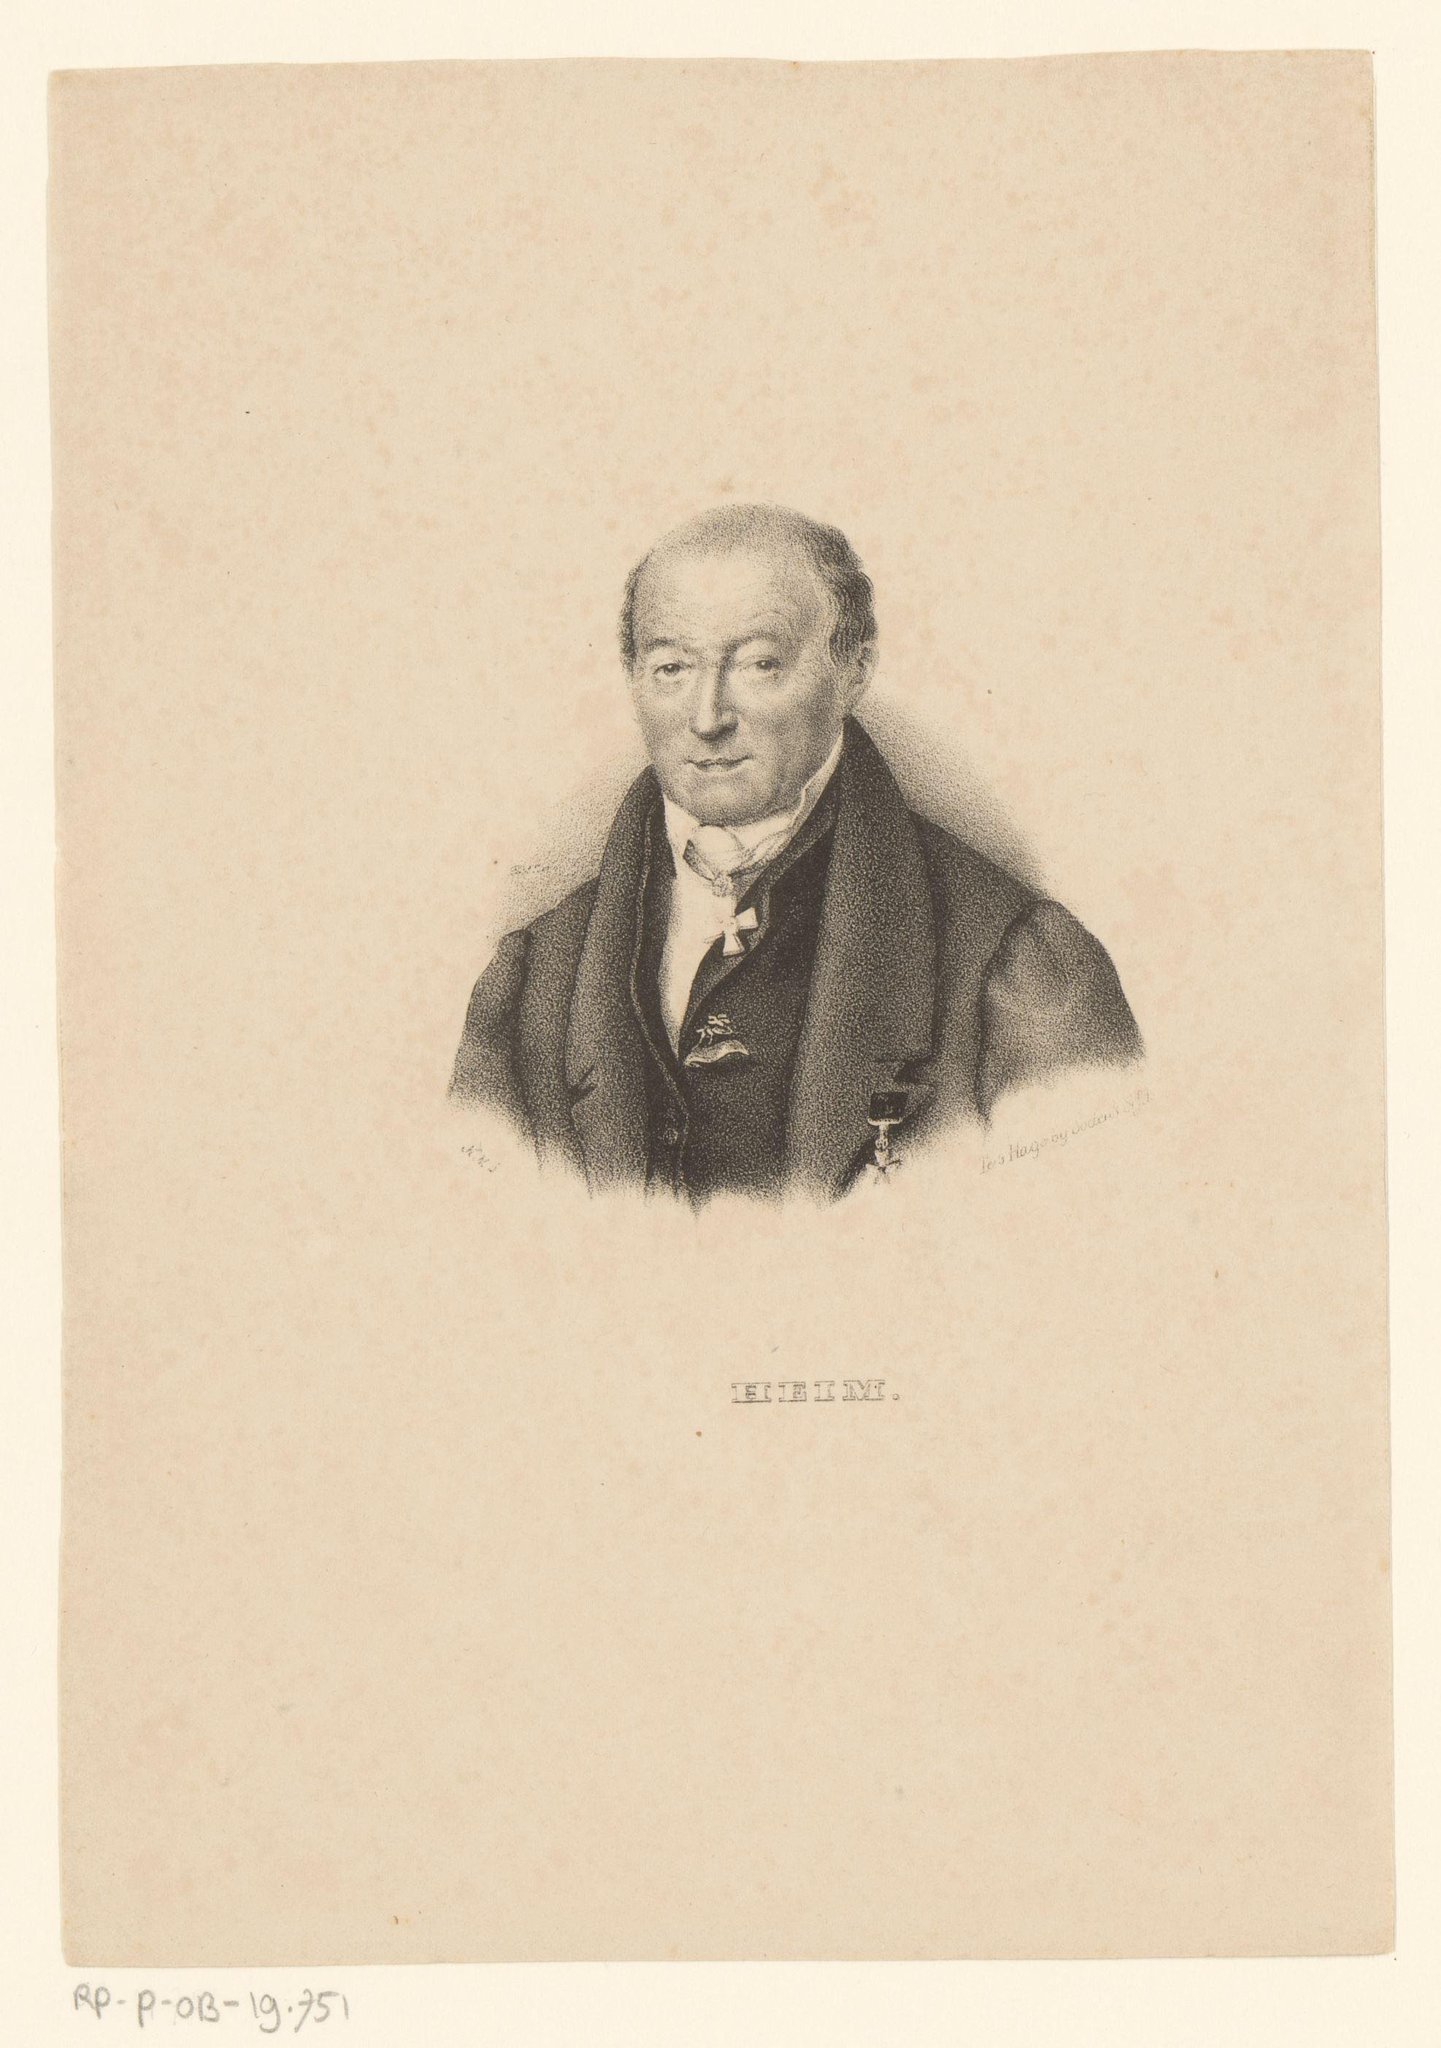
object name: print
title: Portret van Ernst Ludwig Heim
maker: nicolaas martinus schild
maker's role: draughtsman, print maker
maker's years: 1822-1840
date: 1837-1840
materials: paper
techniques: lithograph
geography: the hague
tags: berlin, historical persons (+ (full) bust portrait)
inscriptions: collector's mark: Lugt 2228